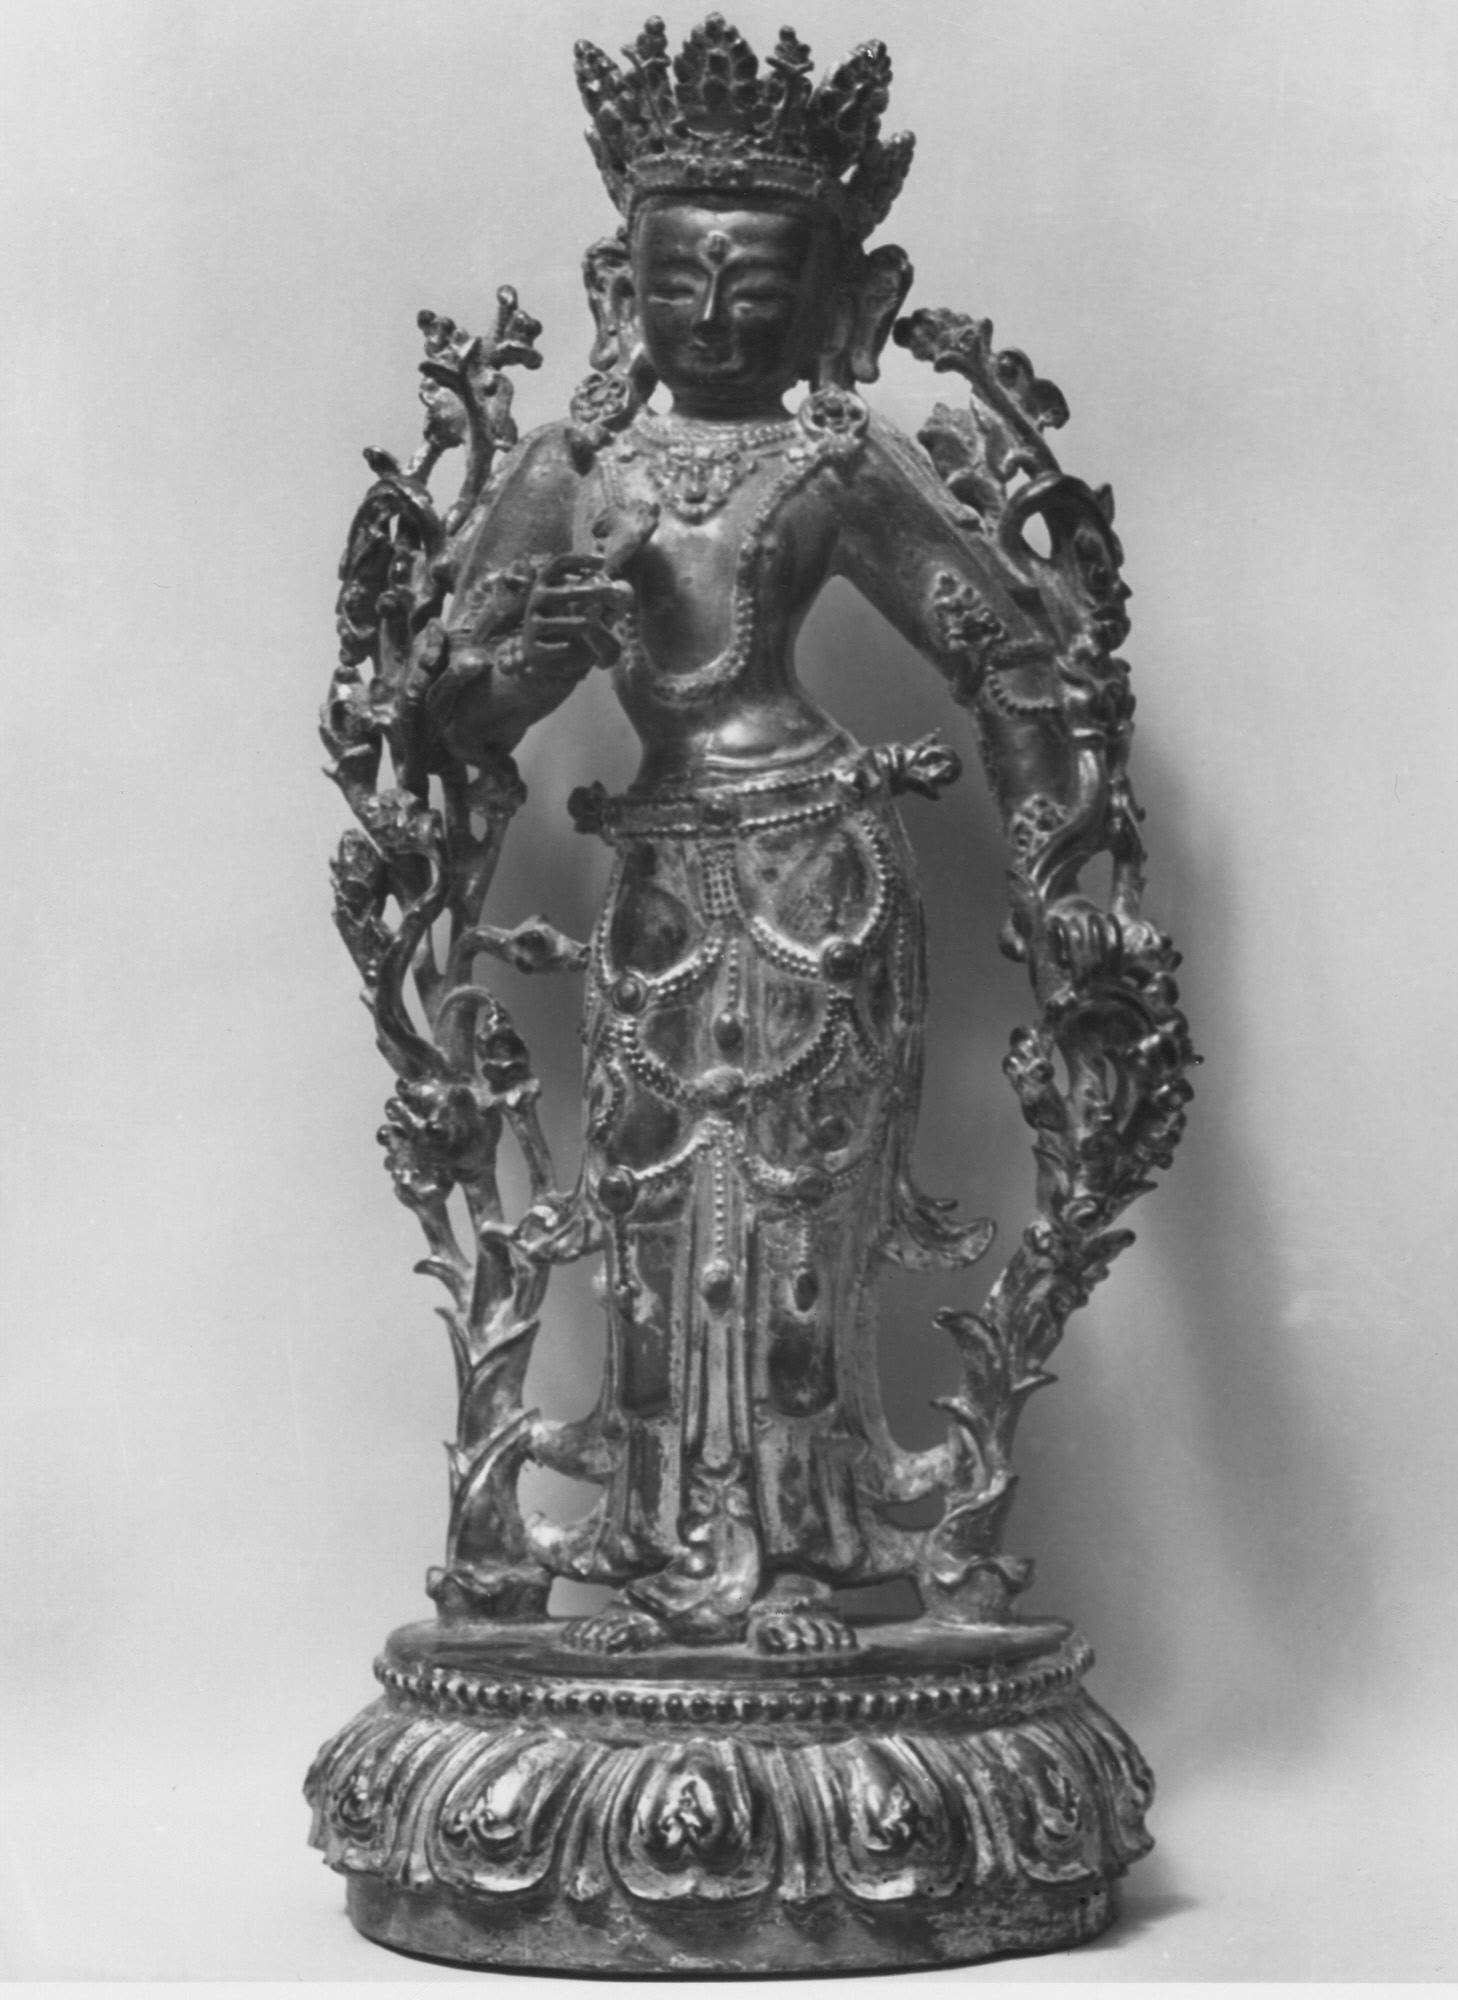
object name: statuette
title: Standing Deity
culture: tibetan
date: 1601-1700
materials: gilt, lacquer, wood